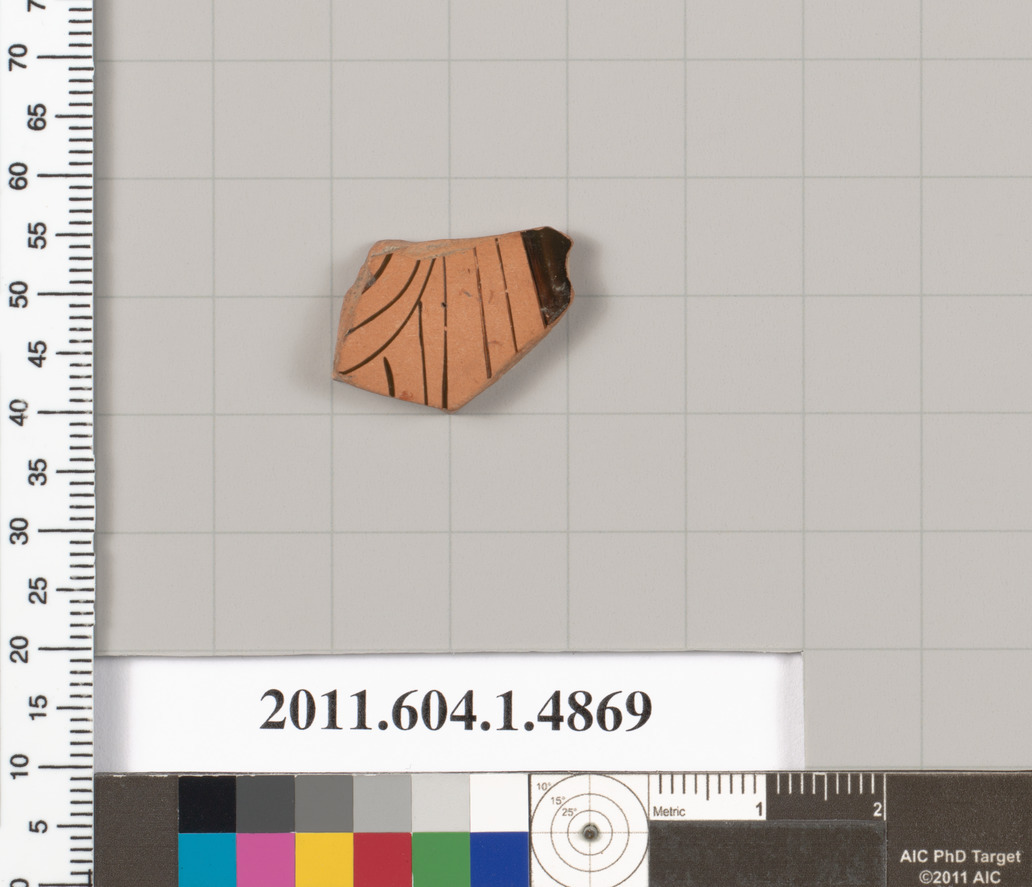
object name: kylix fragment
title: Terracotta fragment of a kylix (drinking cup)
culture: greek, attic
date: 475-451 BCE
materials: terracotta